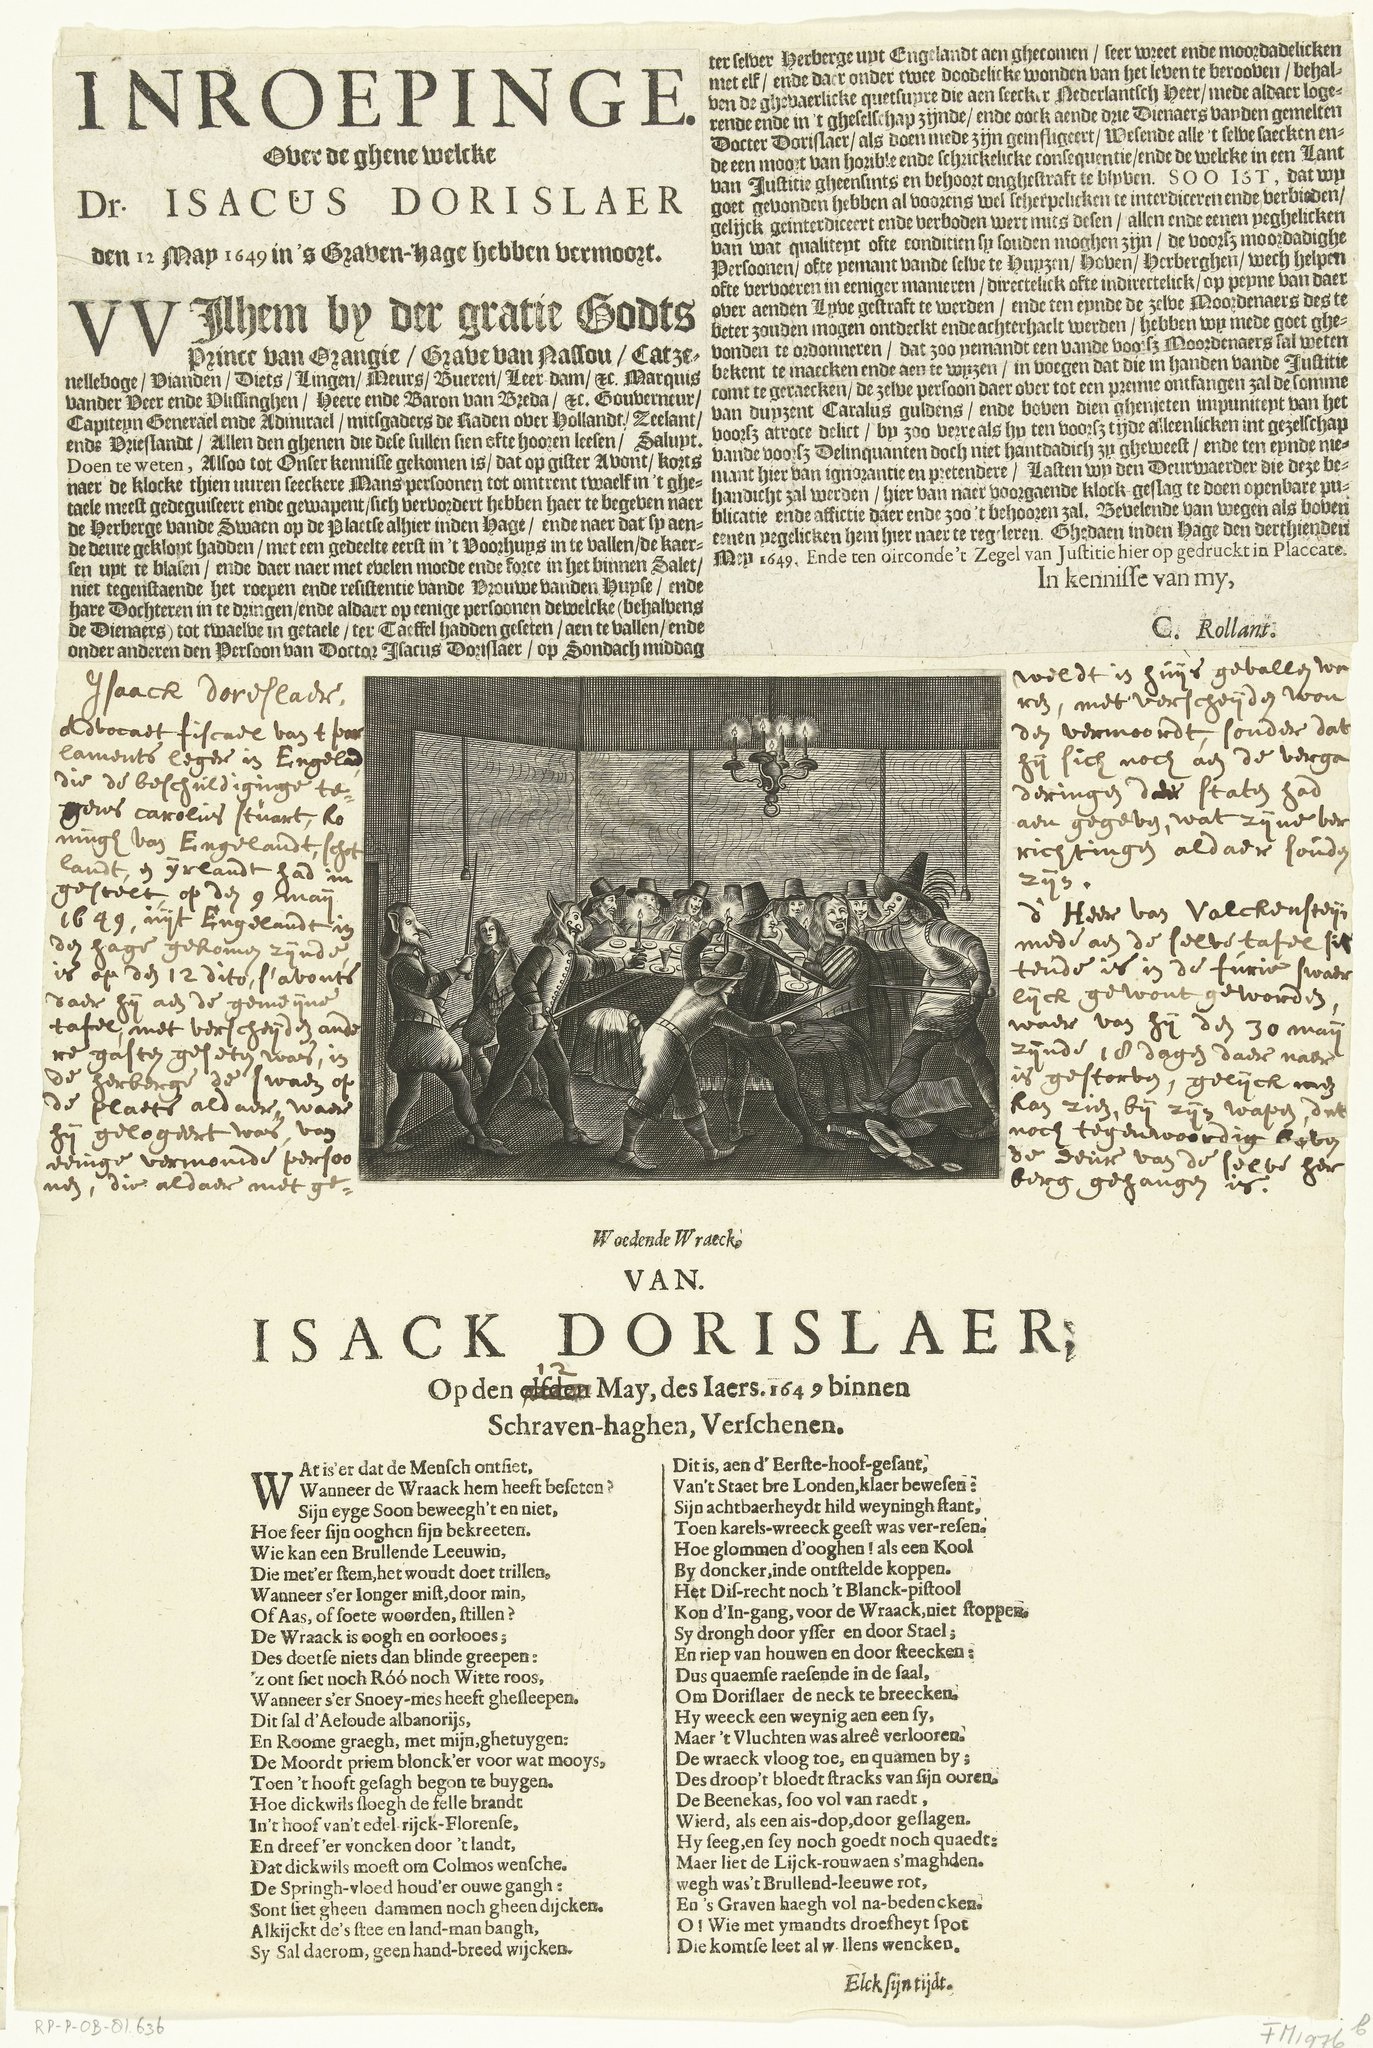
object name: print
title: Inroepinge. Over de ghene welcke Dr. Isacus Dorislaer den 12 May 1649 in 's Graven-hage hebben vermoort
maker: Anonymous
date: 1649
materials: paper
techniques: engraving, letterpress printing, writing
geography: northern netherlands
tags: enkhuizen, murder, the hague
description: De prent en vers van de moord gepleegd op Isaäc Dorislaer door een groep gemaskerde mannen in herberg De Zwaan op de Plaats te 's-Gravenhage, 12 mei 1649, gecombineerd op een blad met de bekendmaking van de uitgeloofde beloning van duizend gulden voor het aanwijzen van de moordenaars van Isaäc Doreslaer. Doreslaer was als gezant door Cromwell uit Engeland naar de Republiek gezonden. Aan weerszijden van de prent een eigentijds handschrift waarin vermeld wordt dat de tafelgenoot de heer van Valkenstein ook bij de aanval gewond werd en op 30 mei aan zijn verwondingen is overleden. Het vers is in 2 kolommen gedrukt en gesigneerd: Elck sijn tijdt.